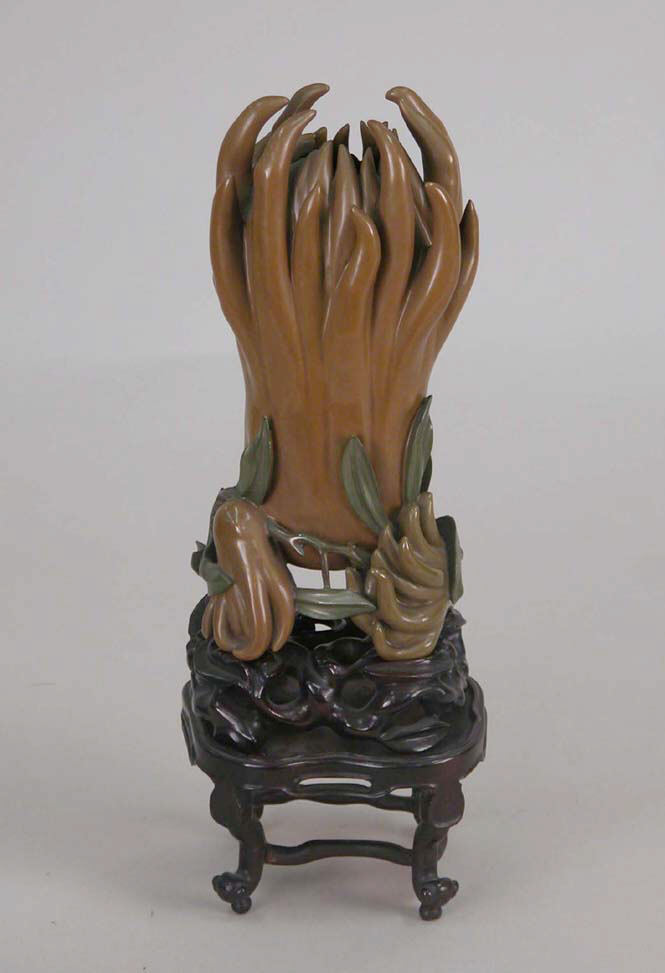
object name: vase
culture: chinese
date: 1801-1900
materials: lacquer, wood